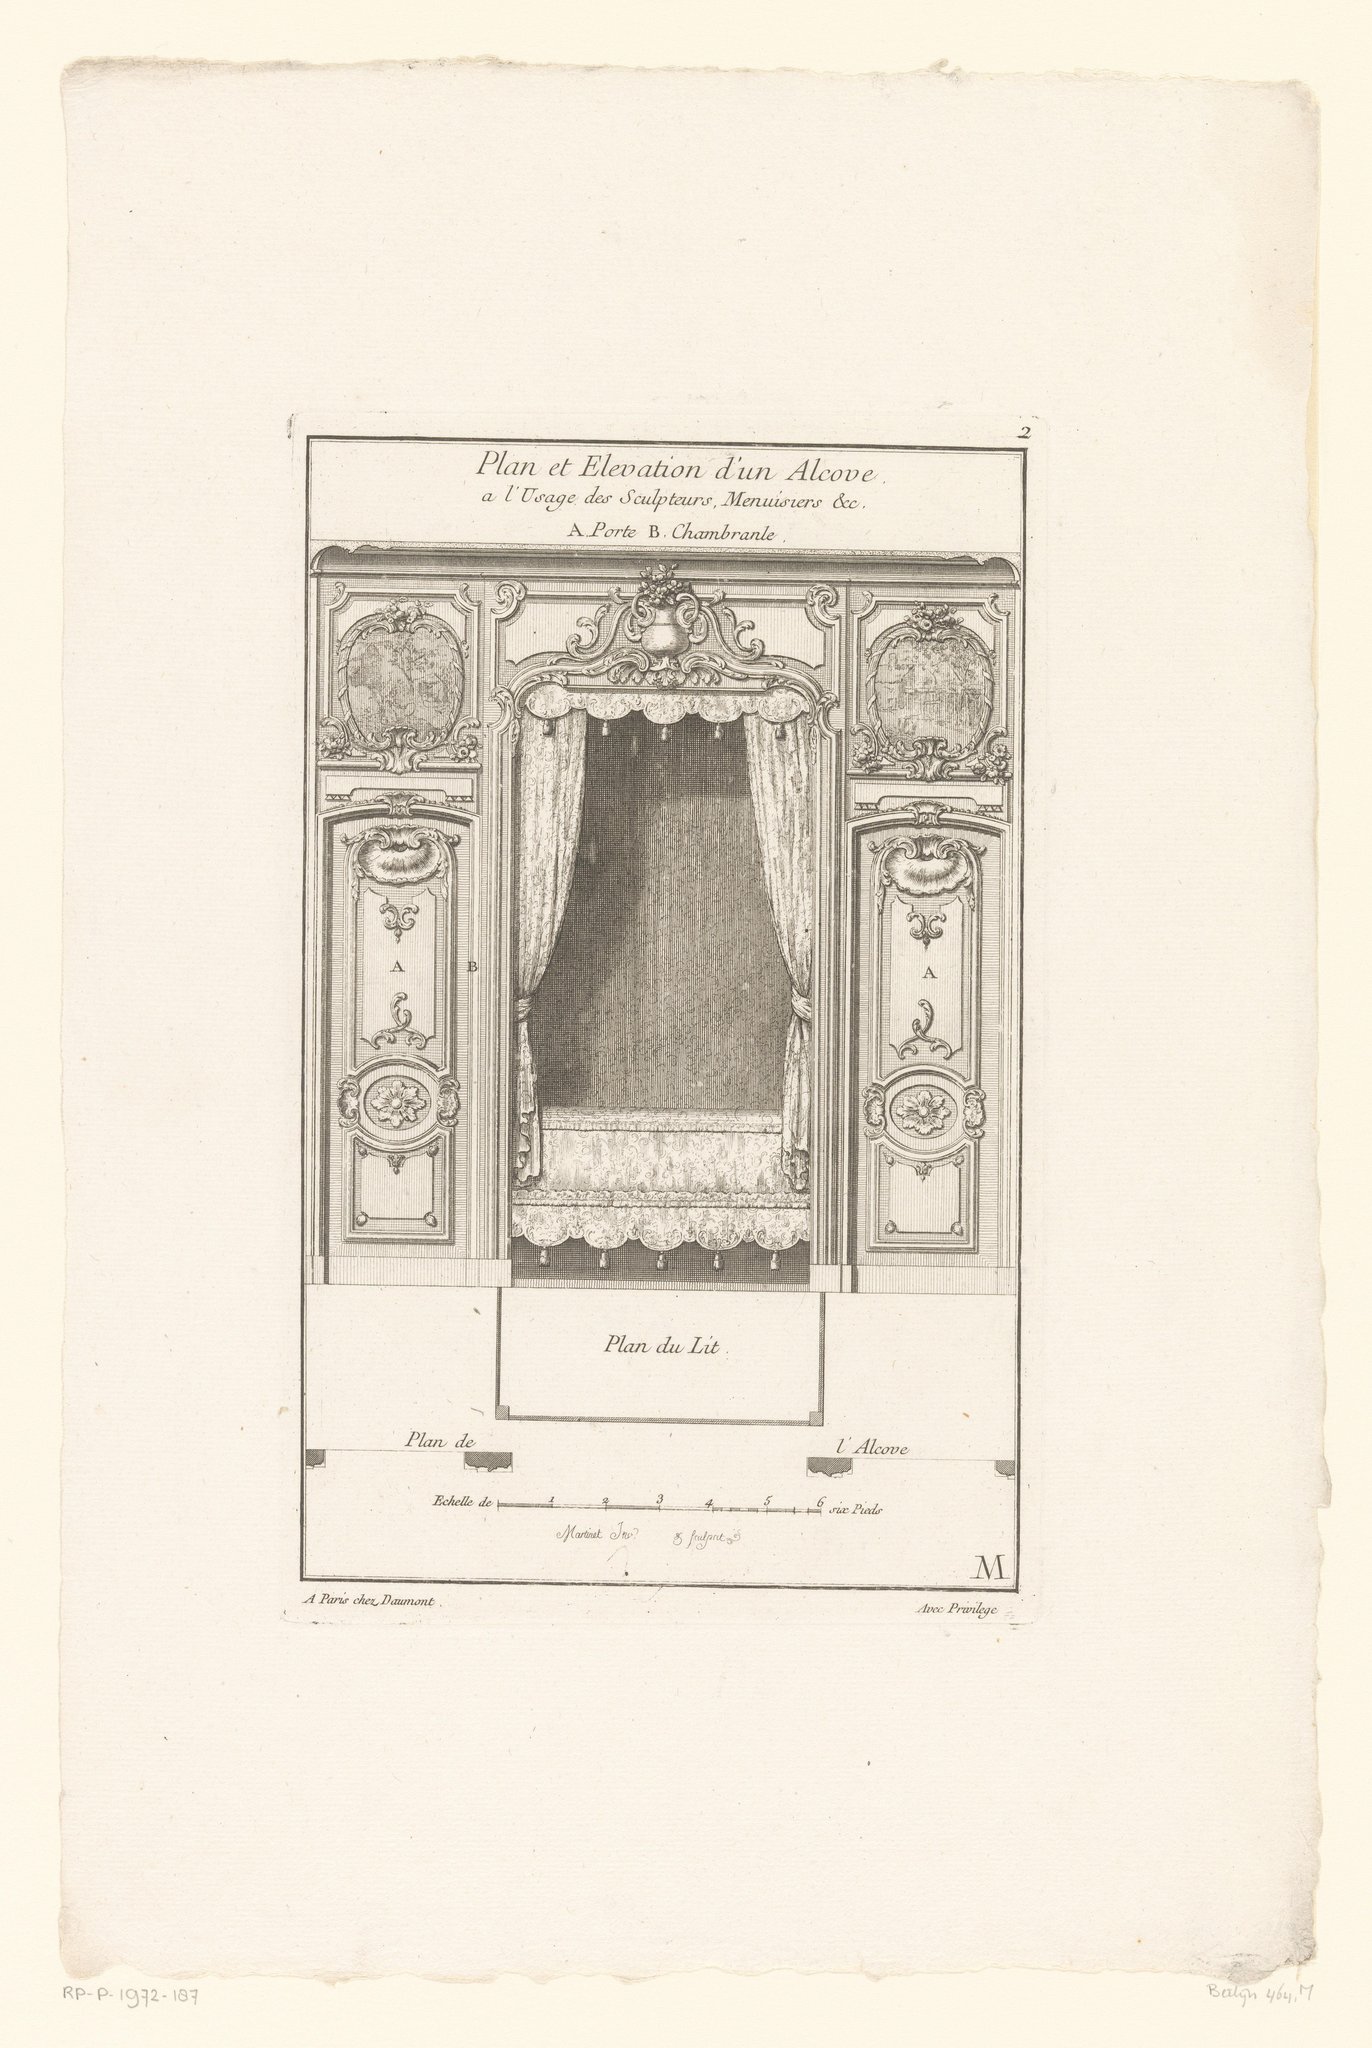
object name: print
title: Alkoof met bed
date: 1745-1775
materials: paper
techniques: engraving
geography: paris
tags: built-in bedstead (dutch: 'bedstee')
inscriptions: collector's mark: Lugt 2760, collector's mark: Lugt 2228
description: Plattegrond en vooraanzicht van een alkoof met gordijnen en een bed. Aan weerszijden van de alkoof rocaille panelen met bloemmotief en een afbeelding van een landschap. Boven de alkoof een vaas met bloemen.